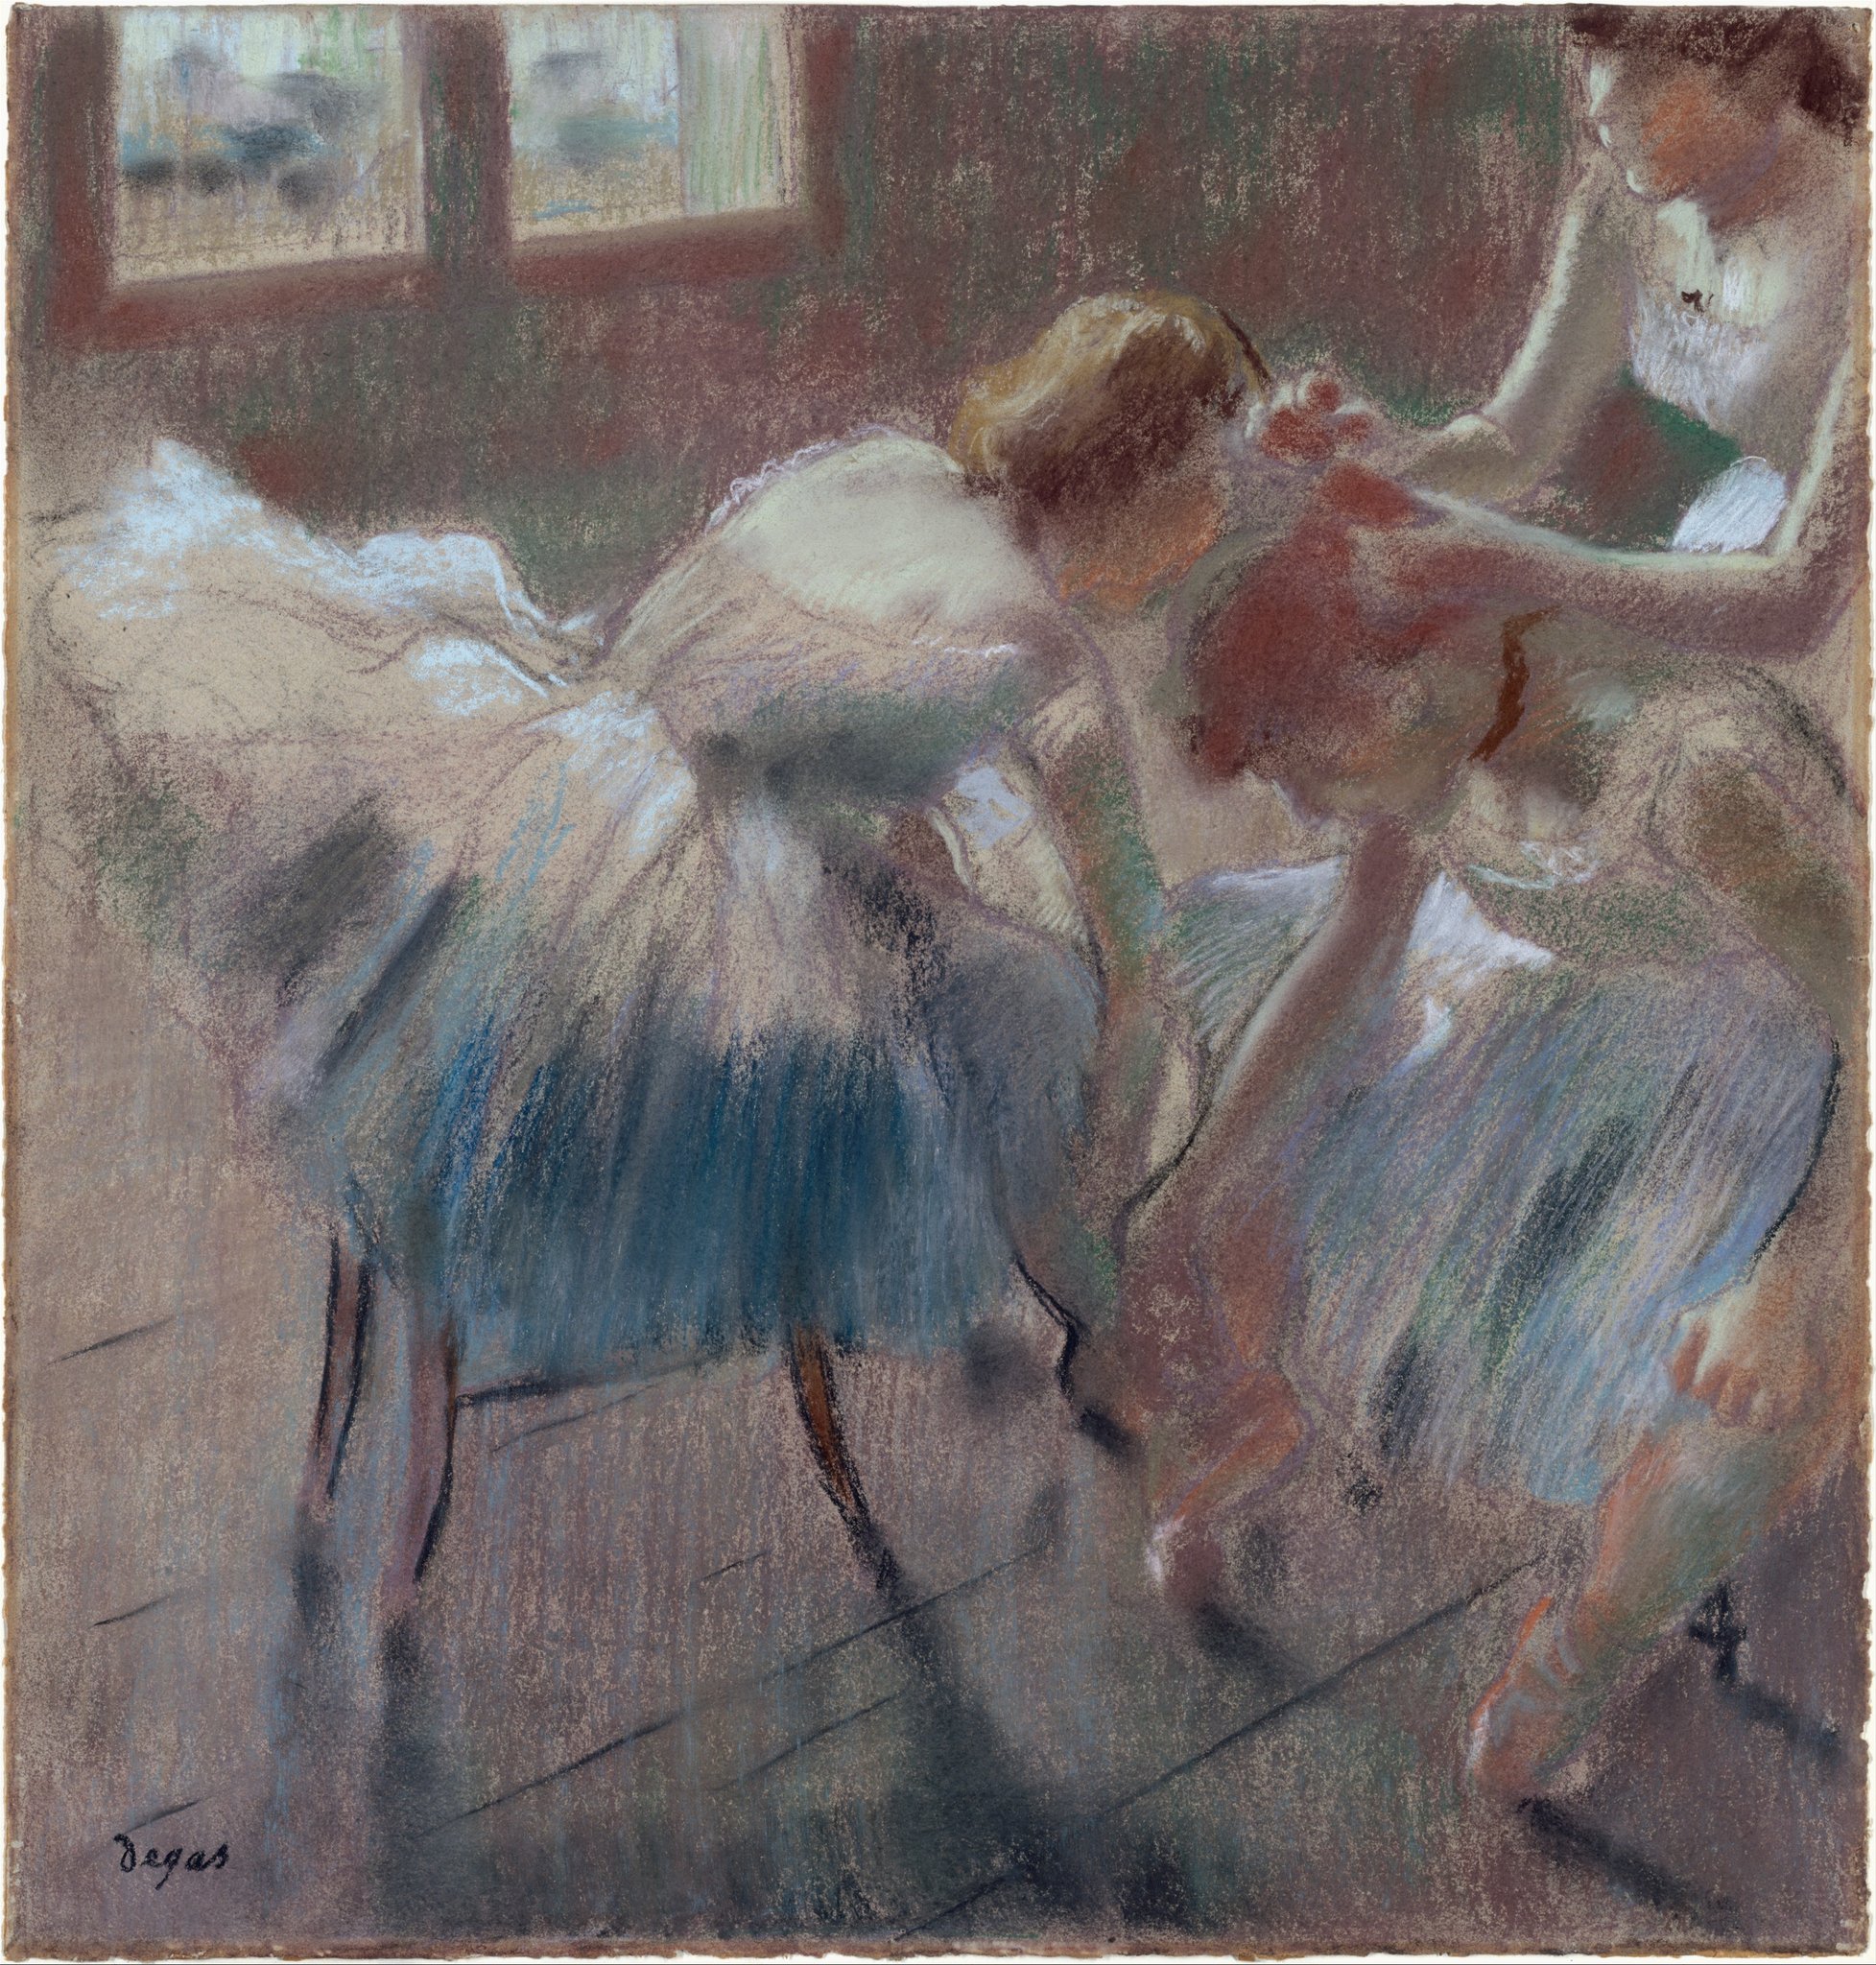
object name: drawing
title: Three Dancers Preparing for Class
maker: edgar degas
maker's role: artist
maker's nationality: french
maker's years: 1834-1917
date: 1878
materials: pastel, paper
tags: women,dancers,ballet